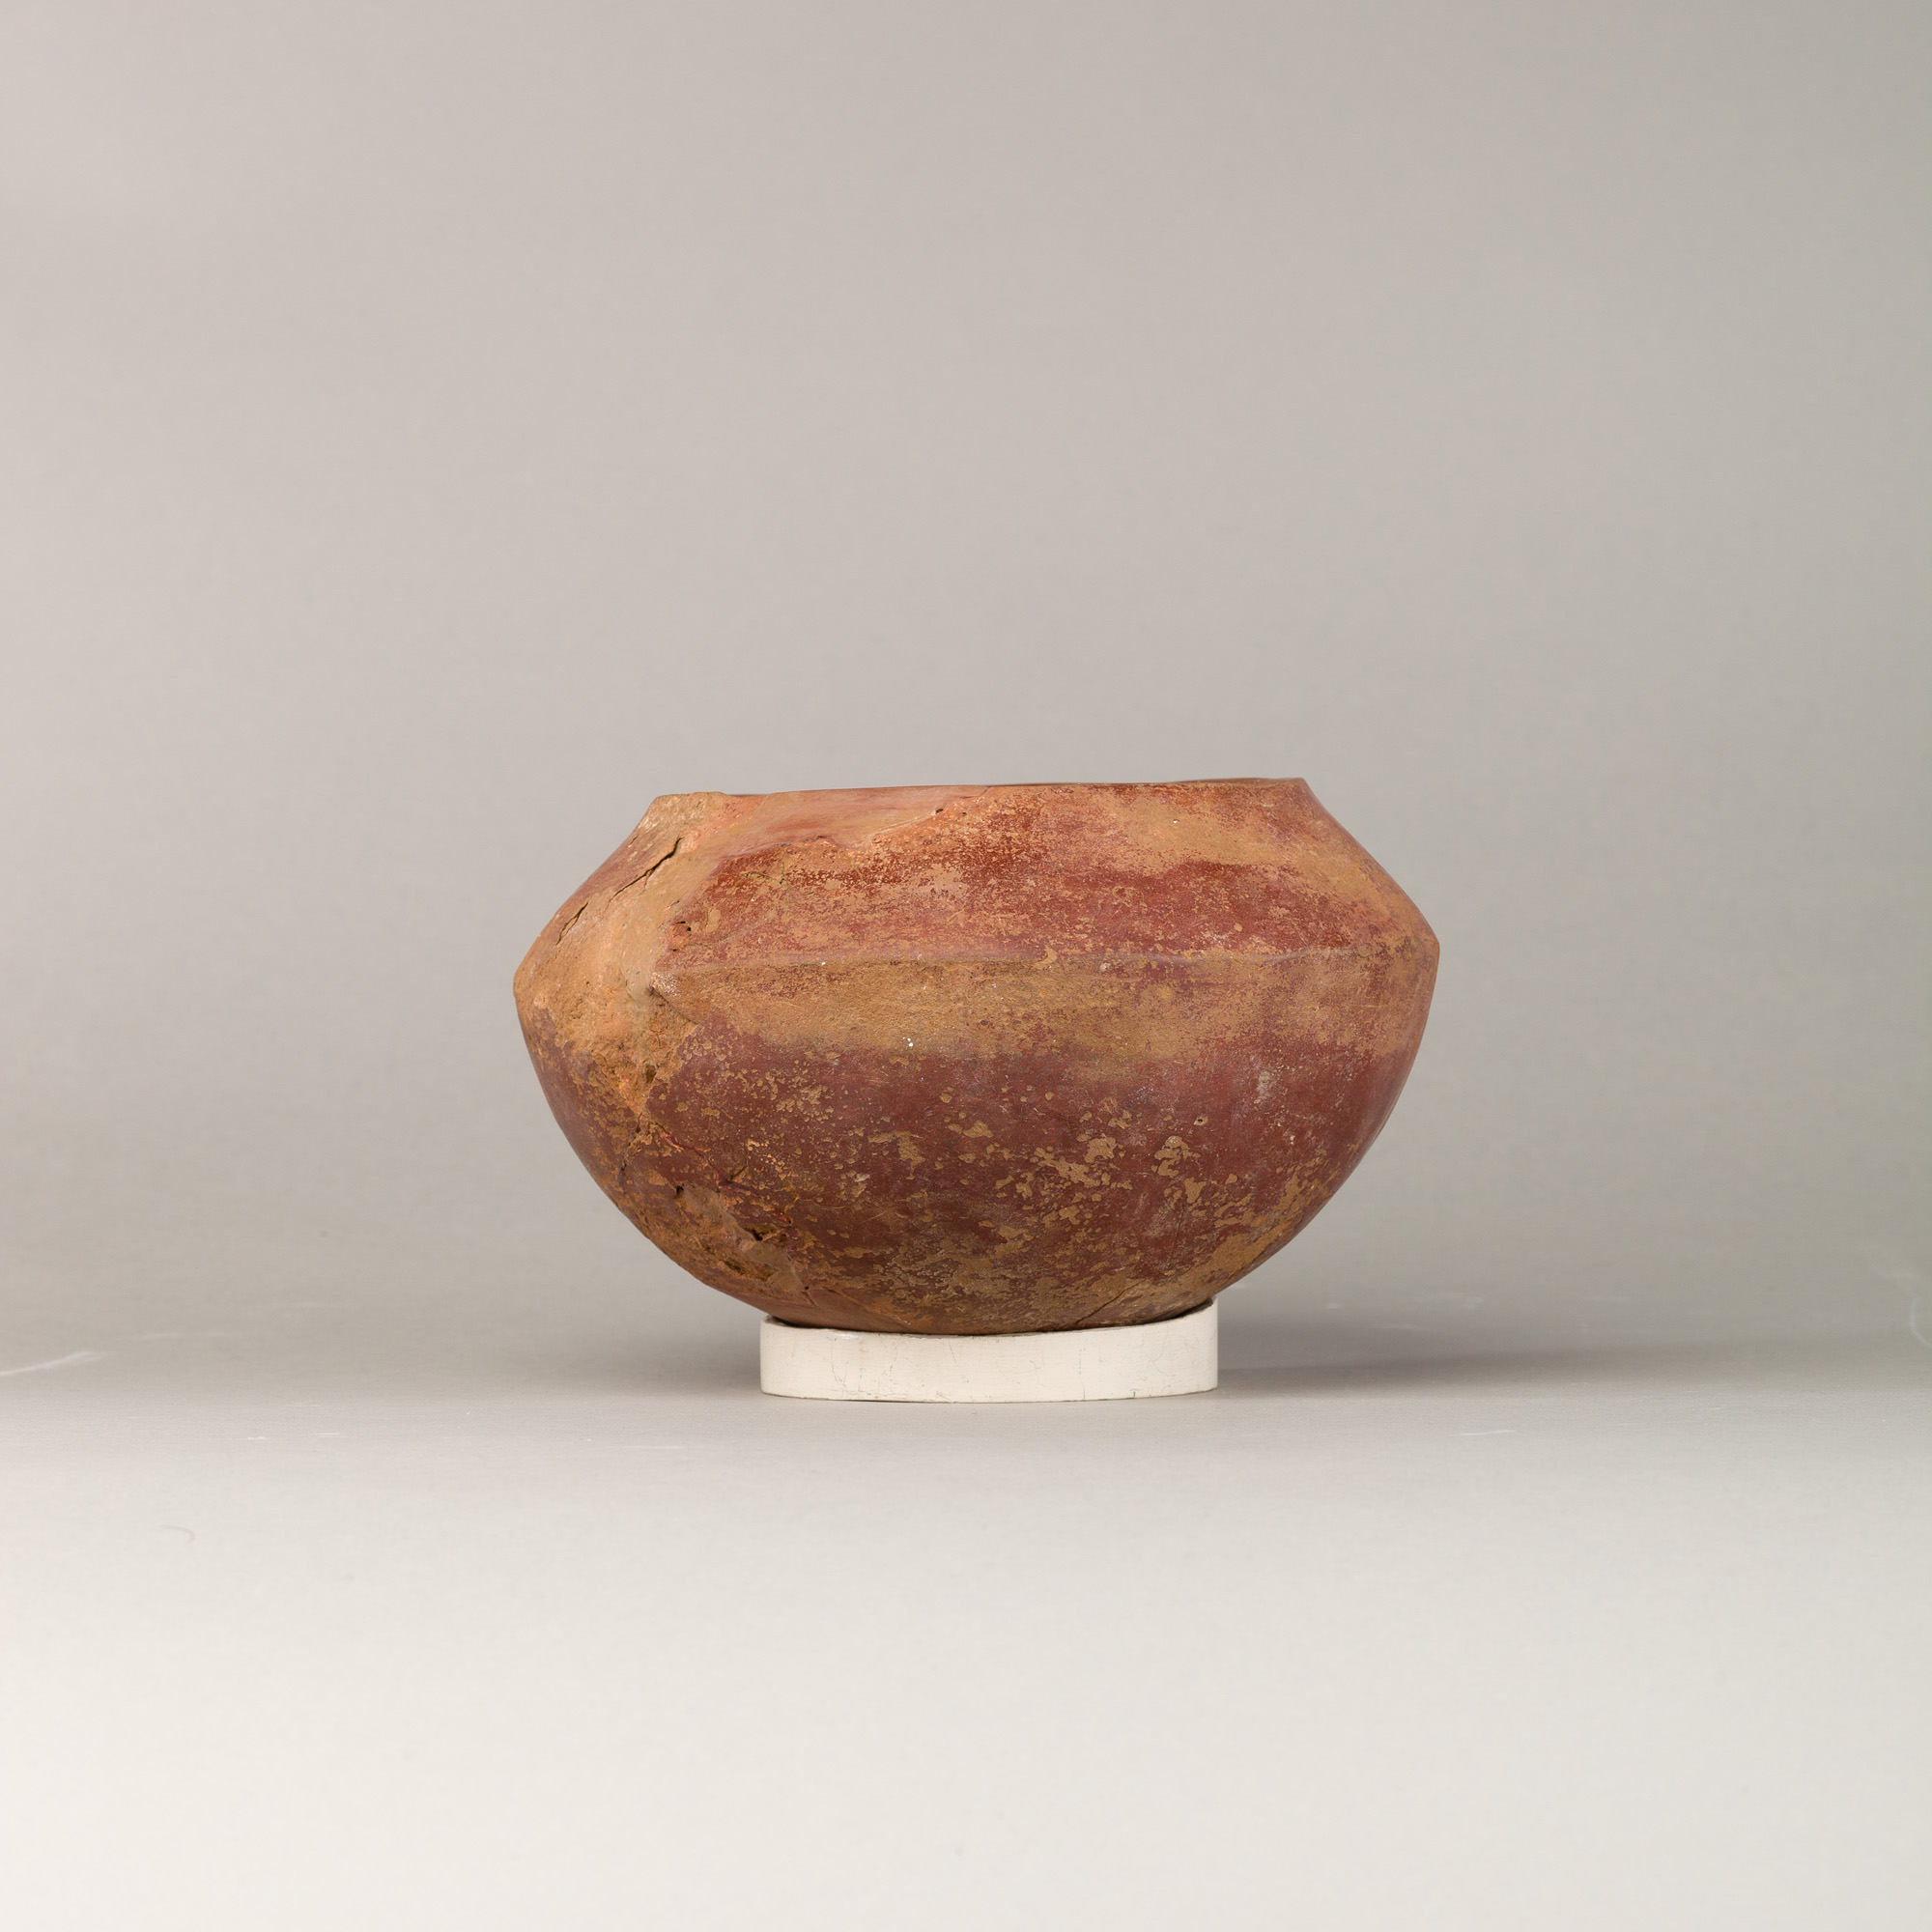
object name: bowl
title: Red polished ware bowl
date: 3850-2960 BCE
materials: pottery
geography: egypt